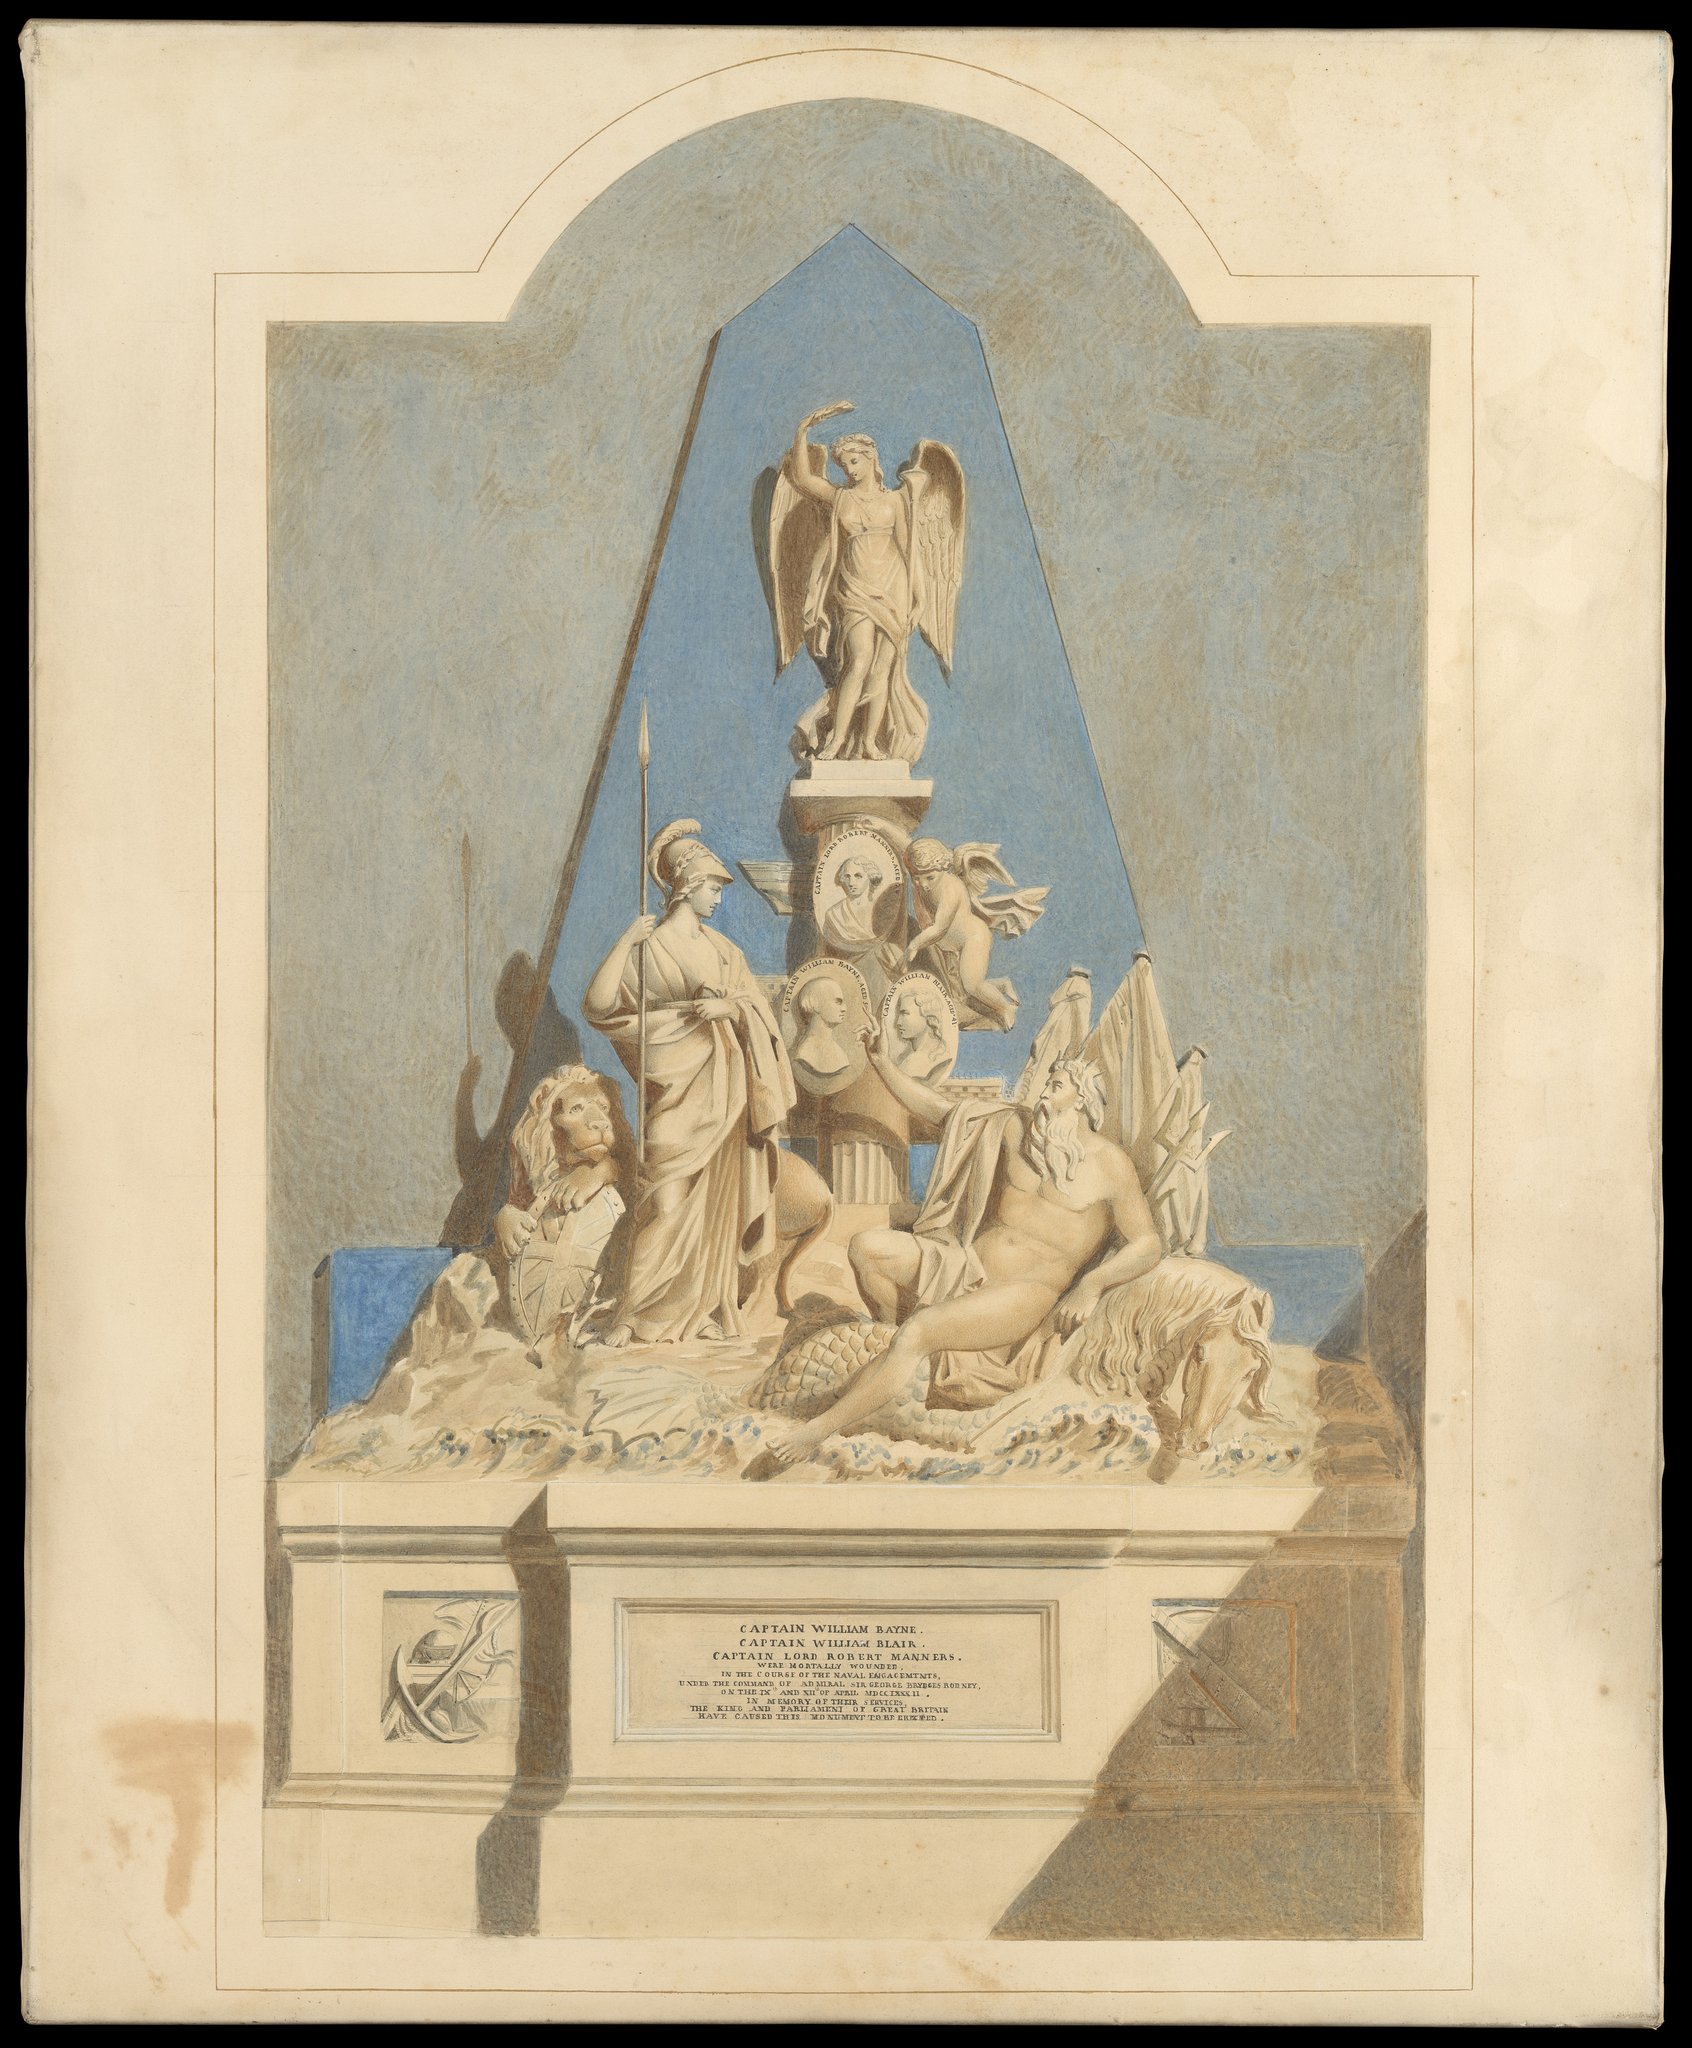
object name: drawing ornament architecture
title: Design for "The Three Captains Memorial"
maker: joseph nollekens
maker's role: artist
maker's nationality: british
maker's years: 1737-1823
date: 1784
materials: canvas, gold, graphite, paper, watercolor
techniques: backing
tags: monuments,neptune,lions